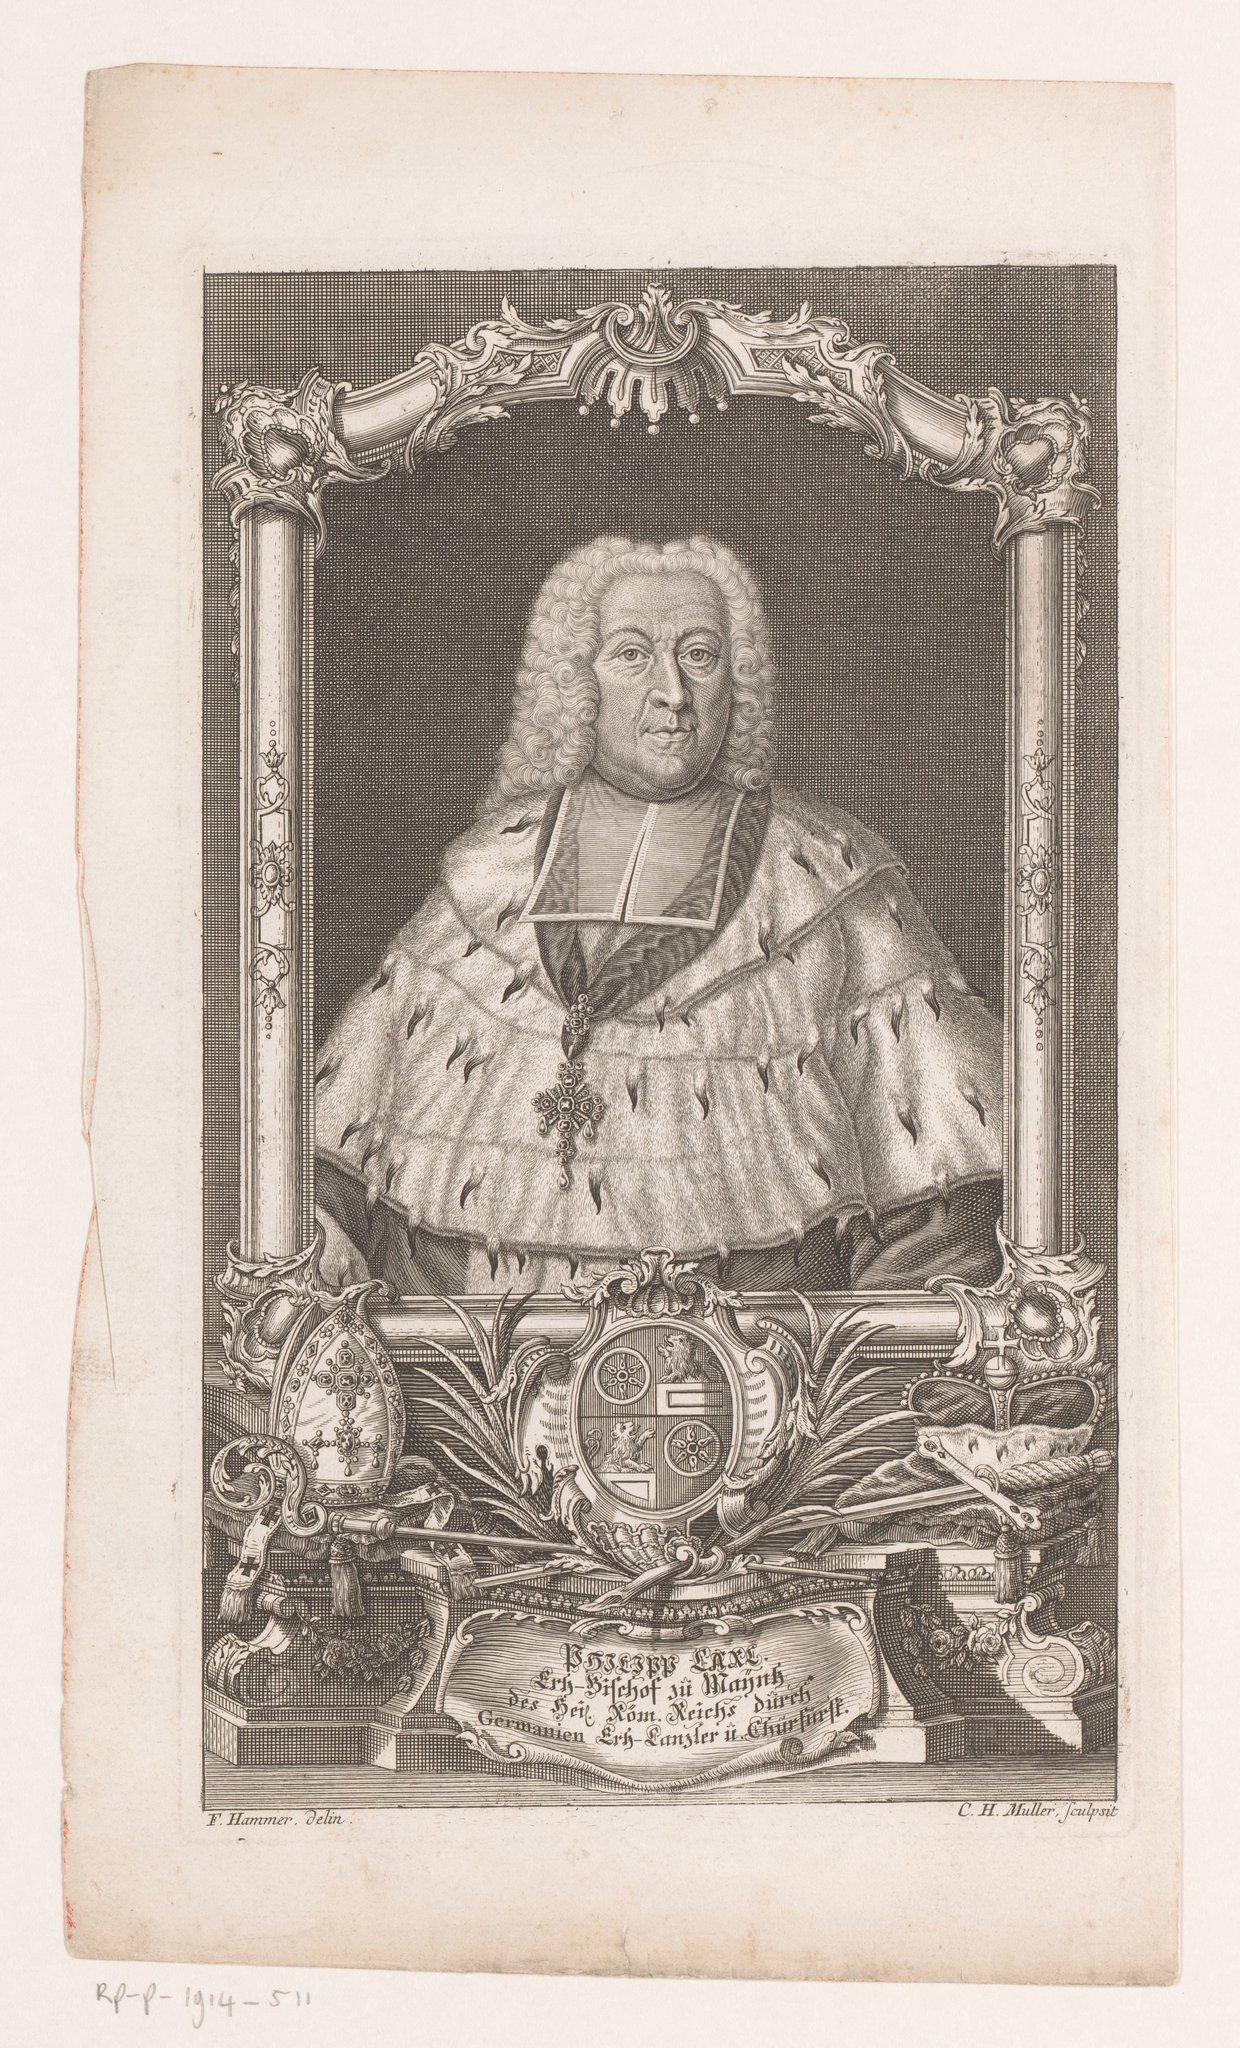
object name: print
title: Portret van Philipp Karl von Eltz-Kempenich, aartsbisschop van Mainz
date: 1732-1799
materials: paper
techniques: engraving, etching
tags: liturgical vestments, canonicals, theologian, historical persons, crucifix ~ personal devotion, armorial bearing, heraldry, insignia and symbols of sovereignty (crown, diadem, sceptre, orb, seal, standard, cloak, pectoral)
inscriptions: collector's mark: Lugt 2228